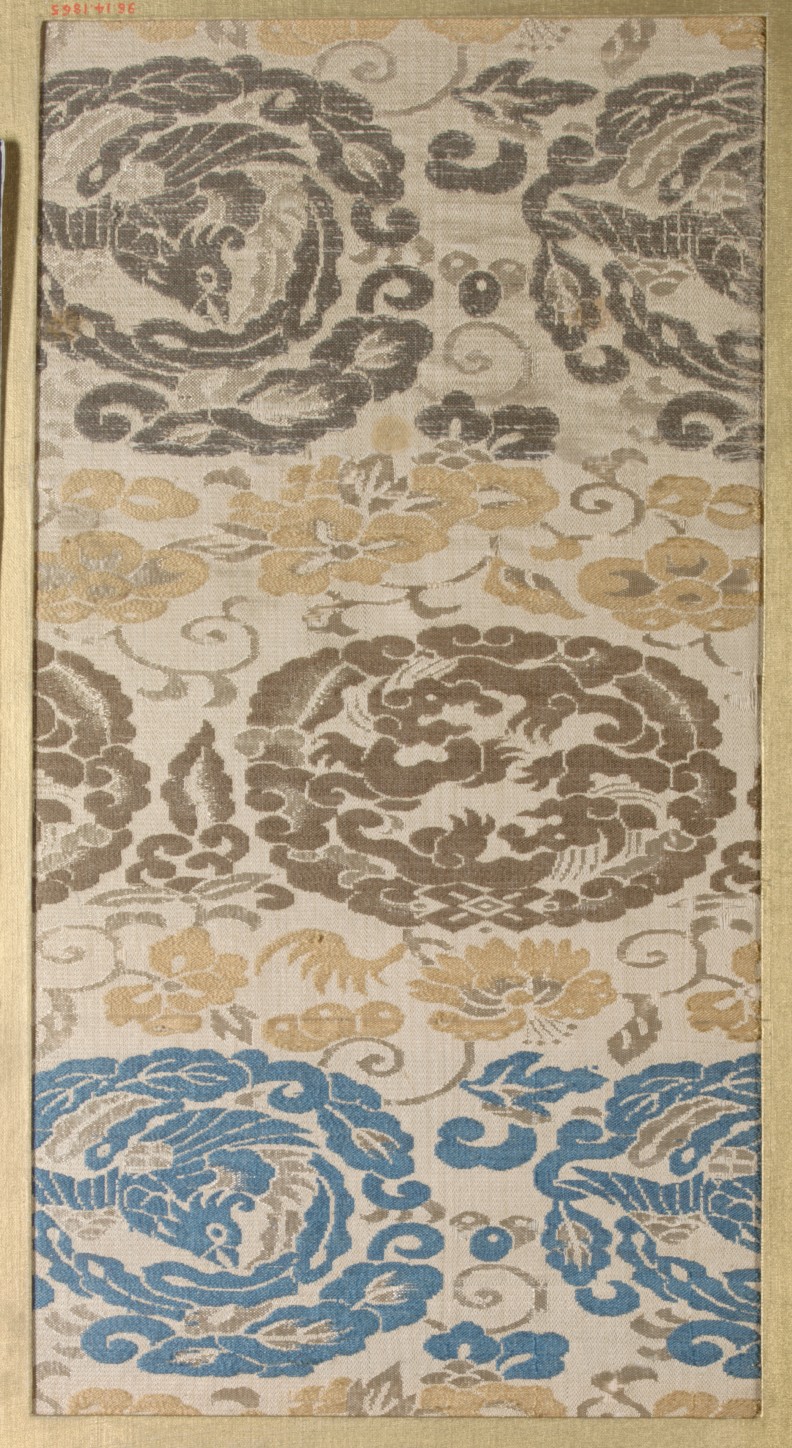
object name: piece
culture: japanese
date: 1701-1900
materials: silk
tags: birds,dragons